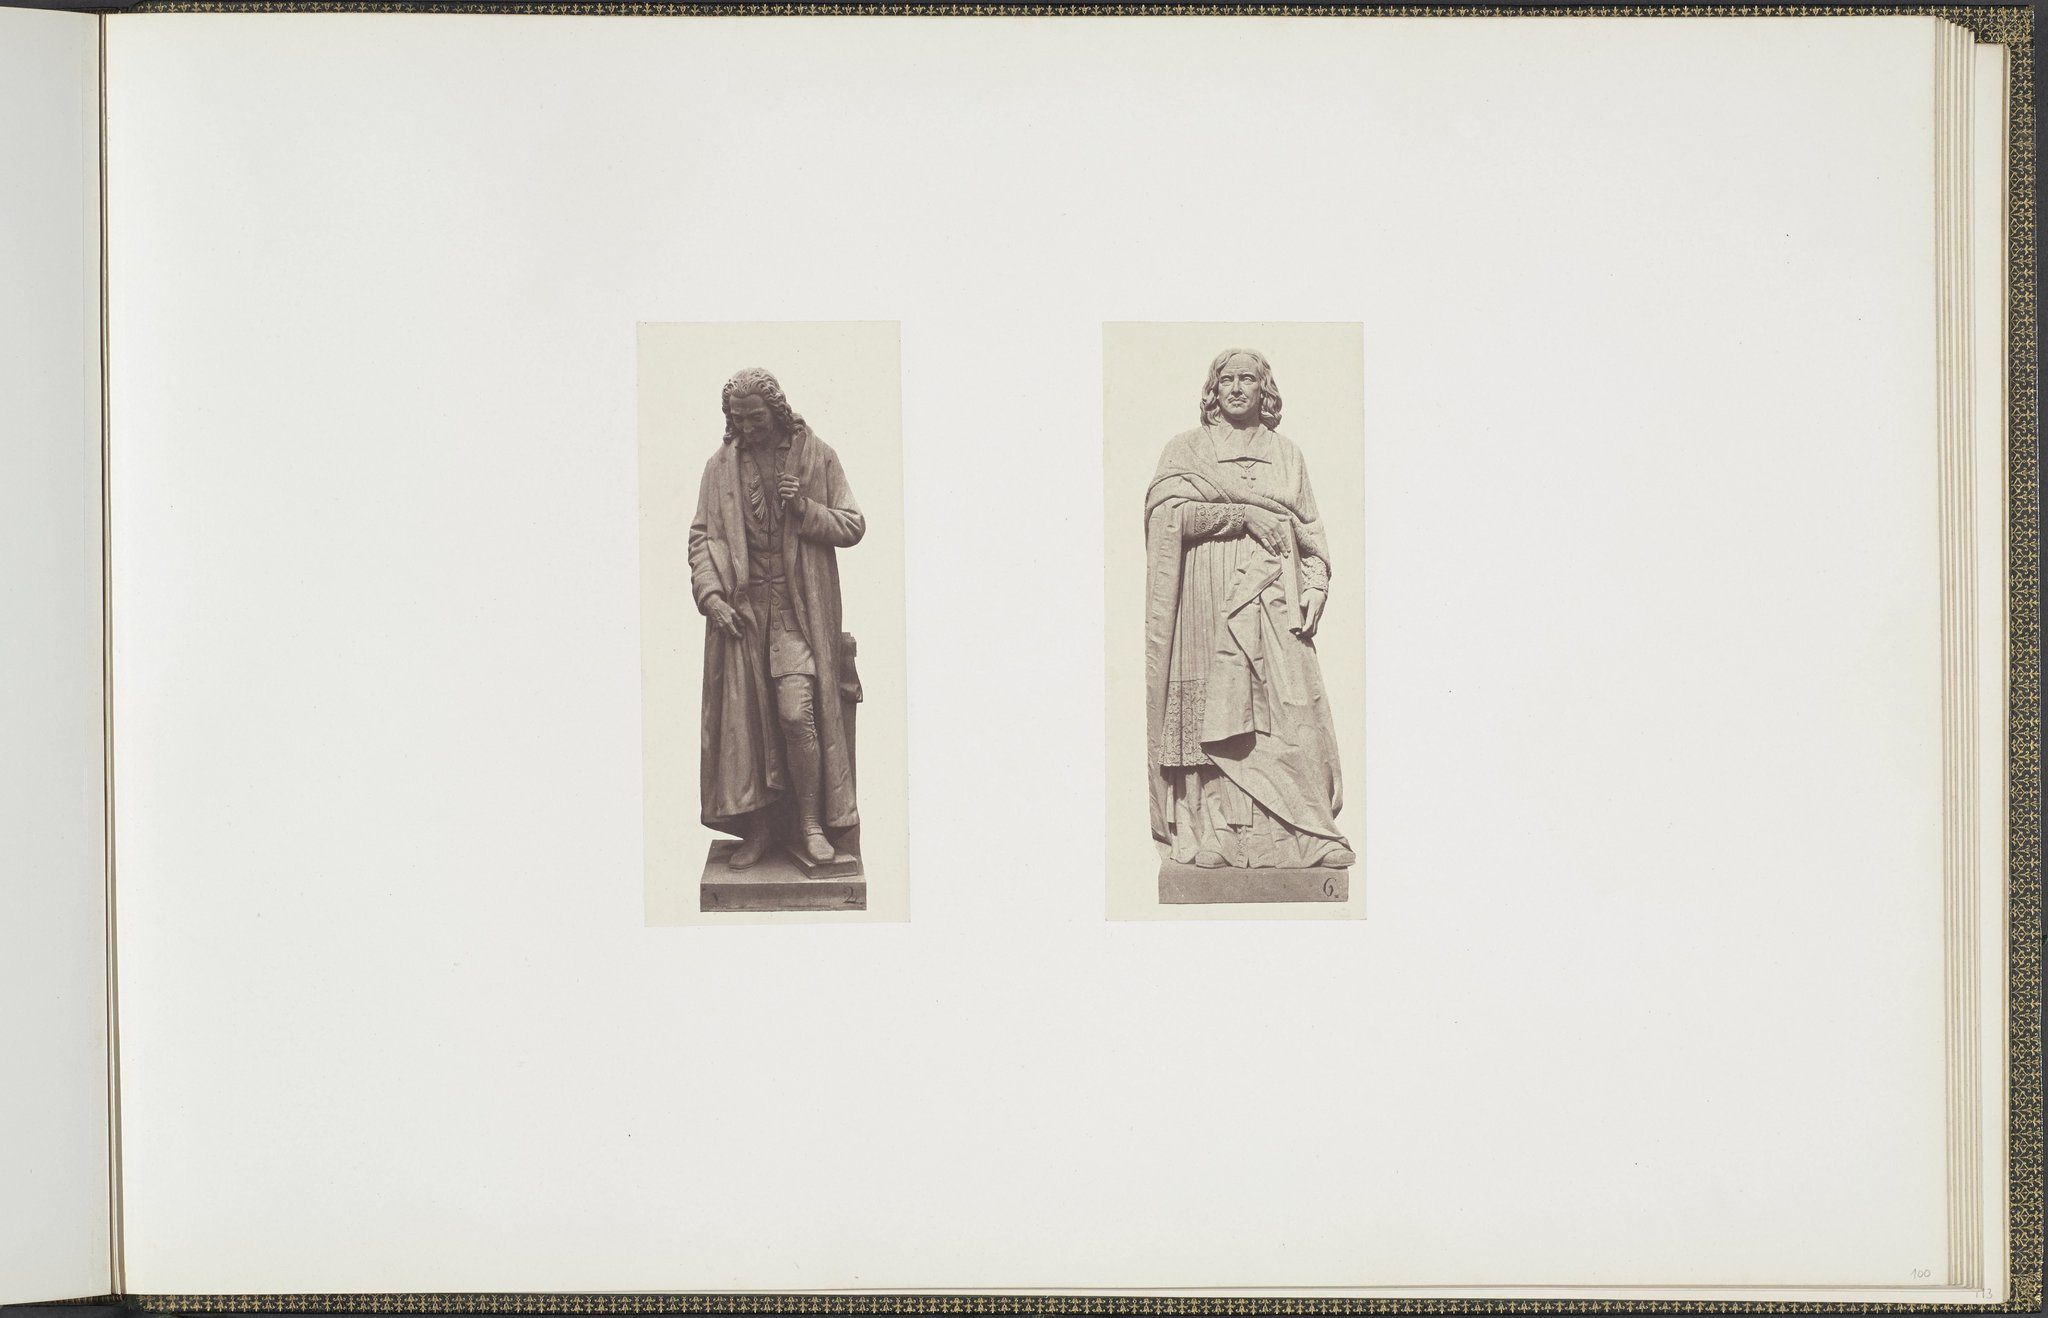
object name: photograph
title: Gipsmodellen voor beeldhouwwerken op het Palais du Louvre: links "Voltaire" door Antoine Desboeufs en rechts "Bossuet" door Louis Desprez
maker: édouard denis baldus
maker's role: fotograaf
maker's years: 1813-1889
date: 1855-1857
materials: paper, photographic support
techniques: salted paper print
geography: paris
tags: piece of sculpture, reproduction of a piece of sculpture, permanent exhibition, museum, paris, tuileries palace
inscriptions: number: ‘2 en 6’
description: Onderdeel van Réunion des Tuileries au Louvre 1852-1857, album 1.